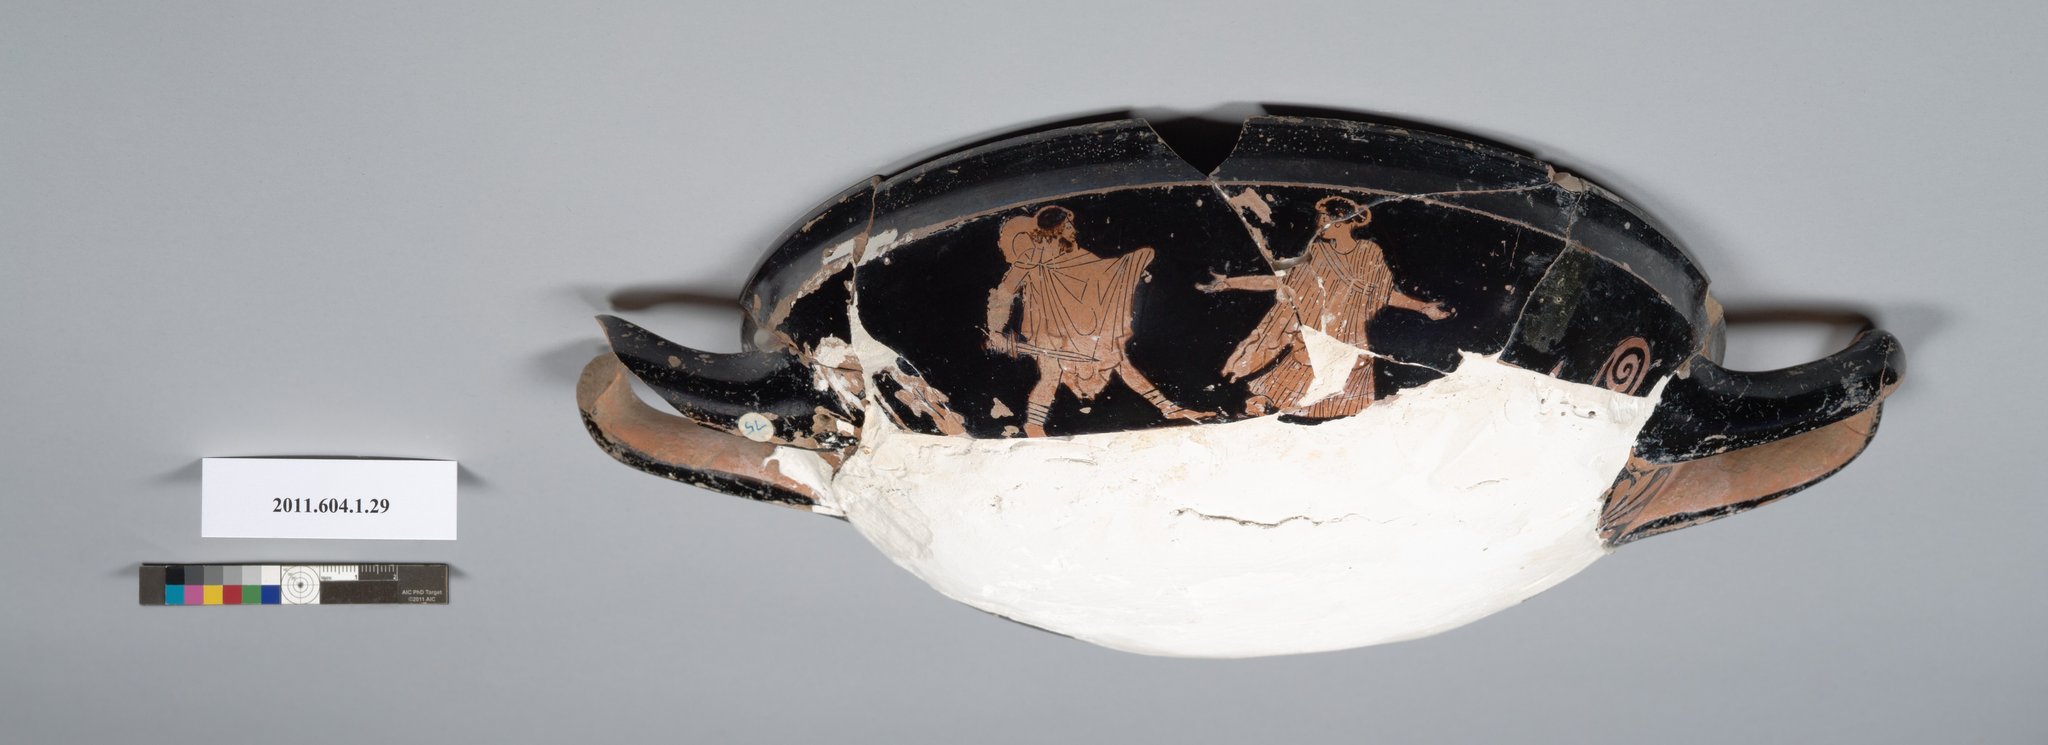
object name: kylix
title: Terracotta kylix (drinking cup)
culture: greek, attic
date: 475-451 BCE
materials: terracotta